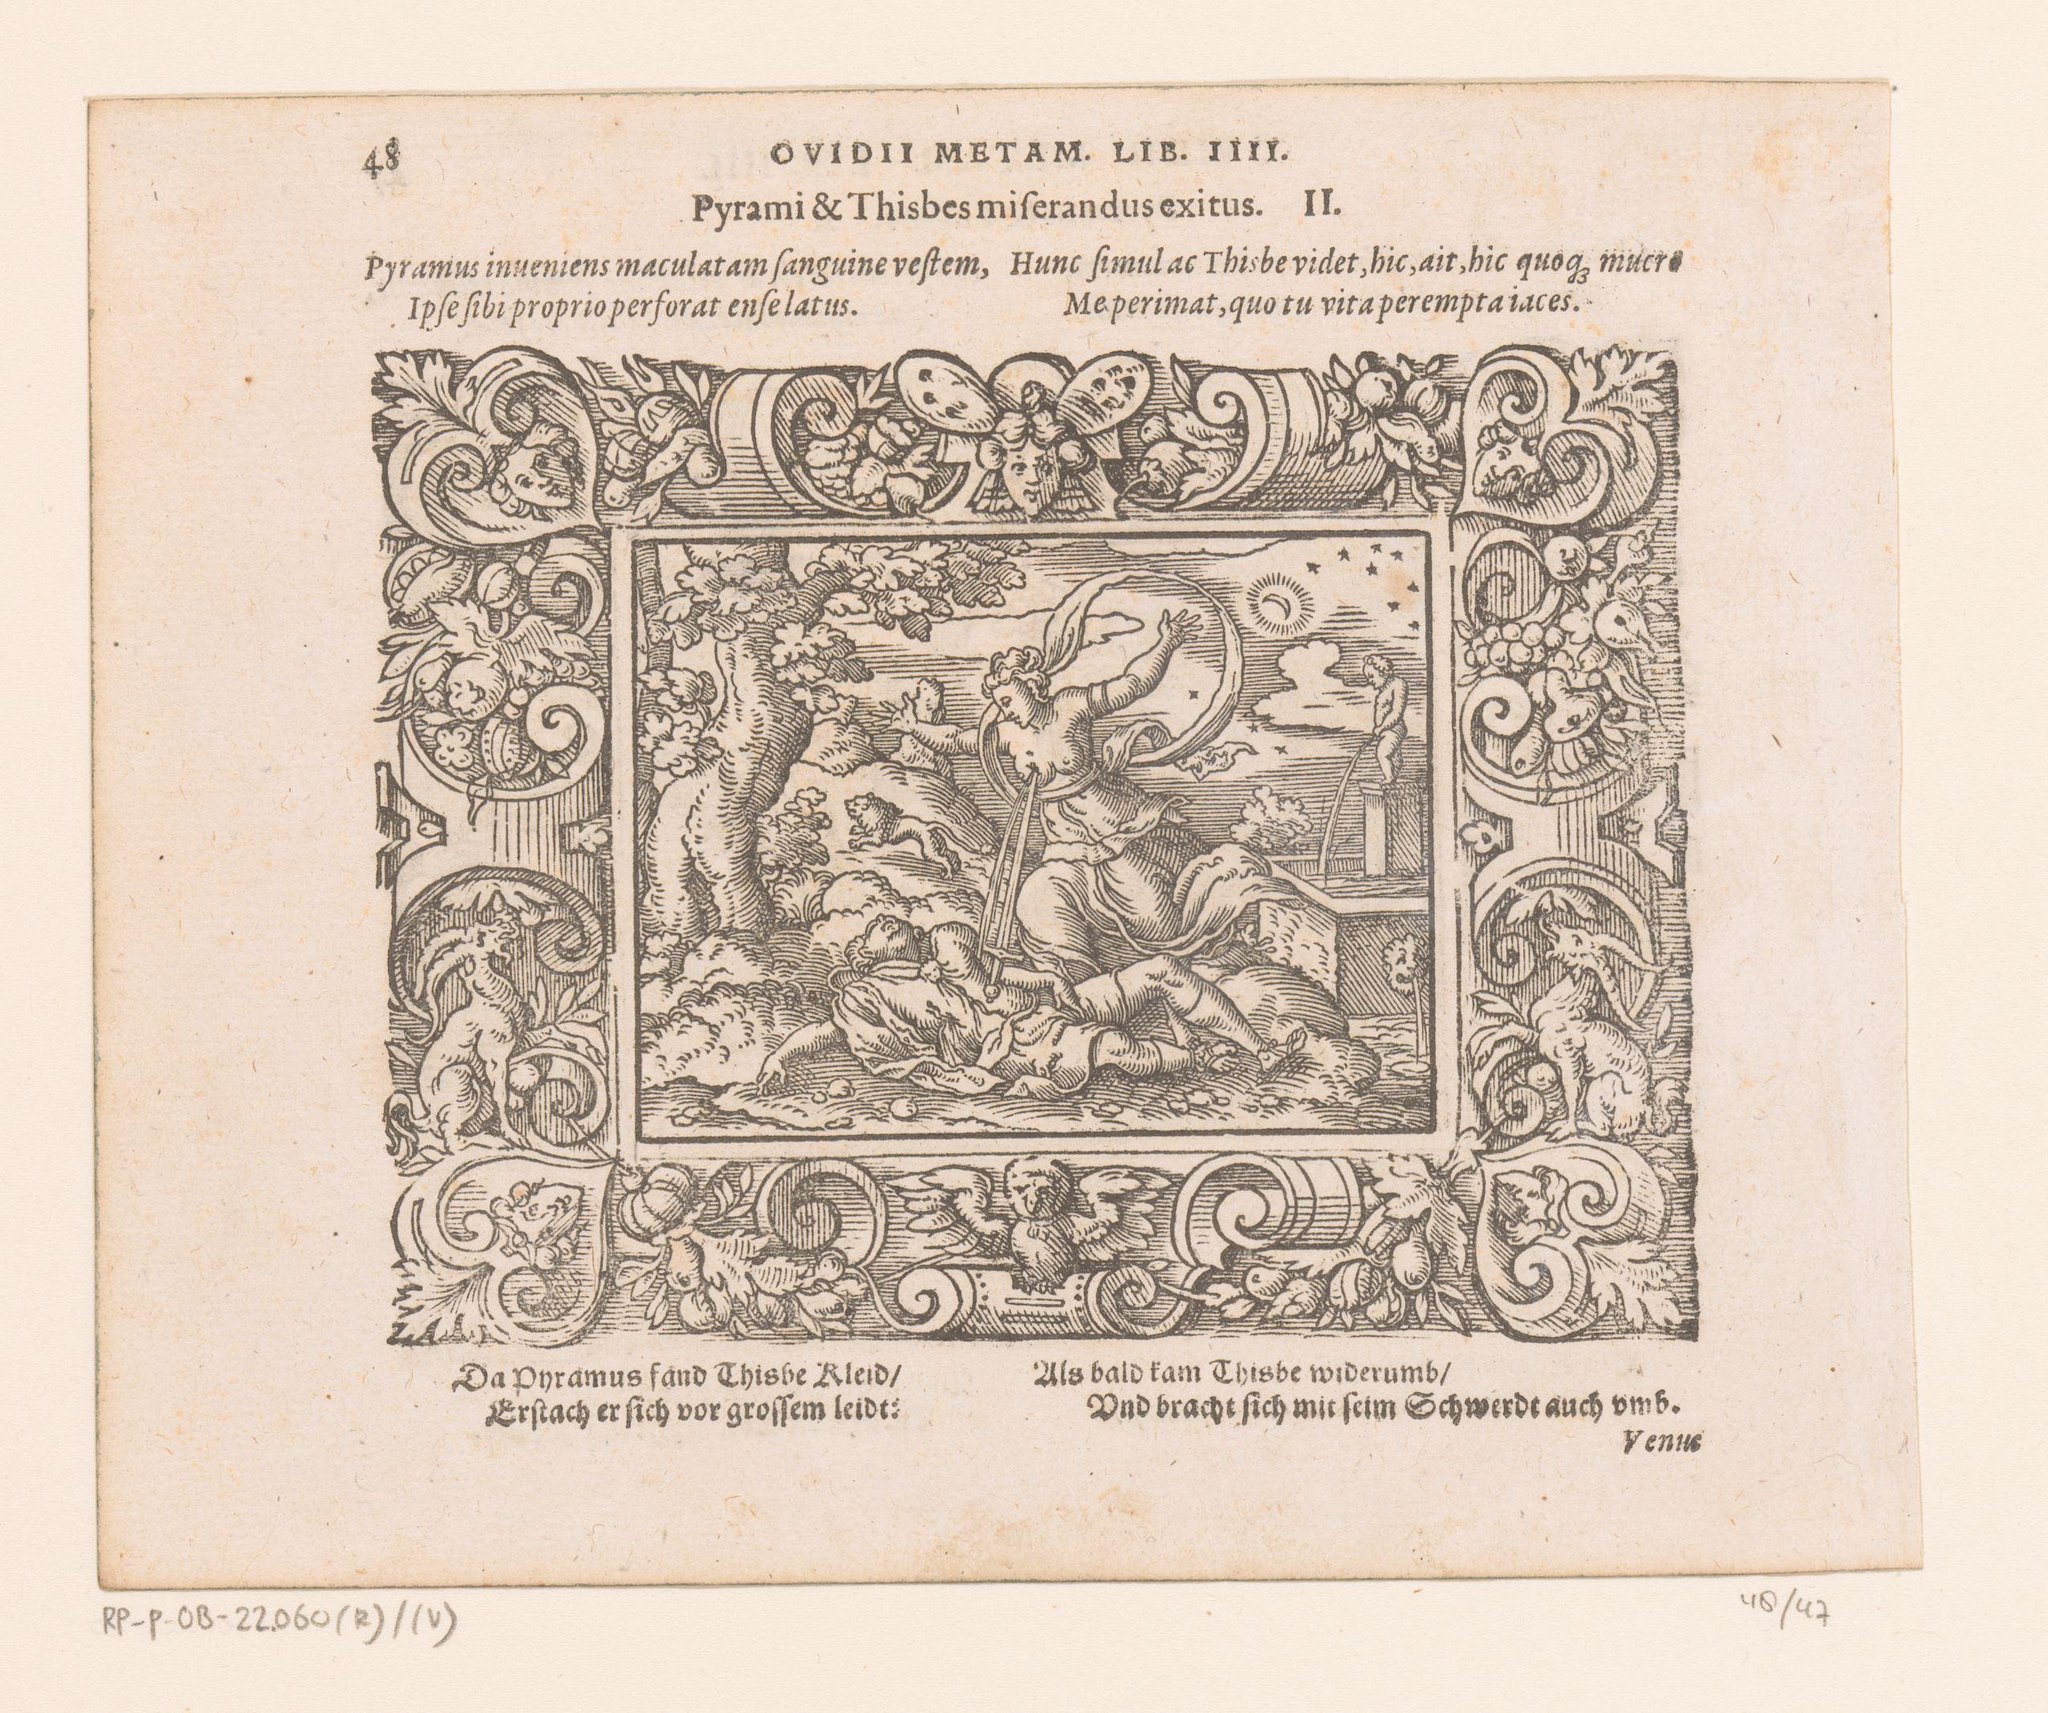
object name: print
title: Thisbe doodt zichzelf met het zwaard van Pyramus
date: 1569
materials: paper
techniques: letterpress printing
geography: frankfurt am main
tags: scrollwork, strapwork ~ ornament, thisbe kills herself with pyramus' sword (the scene may be represented near a fountain)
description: Illustratie bij de Metamorfosen van Ovidius, afkomstig uit de publicatie: Posthius, Johannes. Tetrasticha in Ovidii metam. Frankfurt am Main: Georg Rab en Sigmund Feyerabend en erven Weigand Han, 1569. De voorstellingen en ornamentranden van deze boekillustraties zijn van twee aparte blokken gedrukt. Beide werden afzonderlijk van elkaar ook gebruikt voor andere publicaties, en de ornamentranden werden eveneens binnen deze publicatie meerdere keren gebruikt.